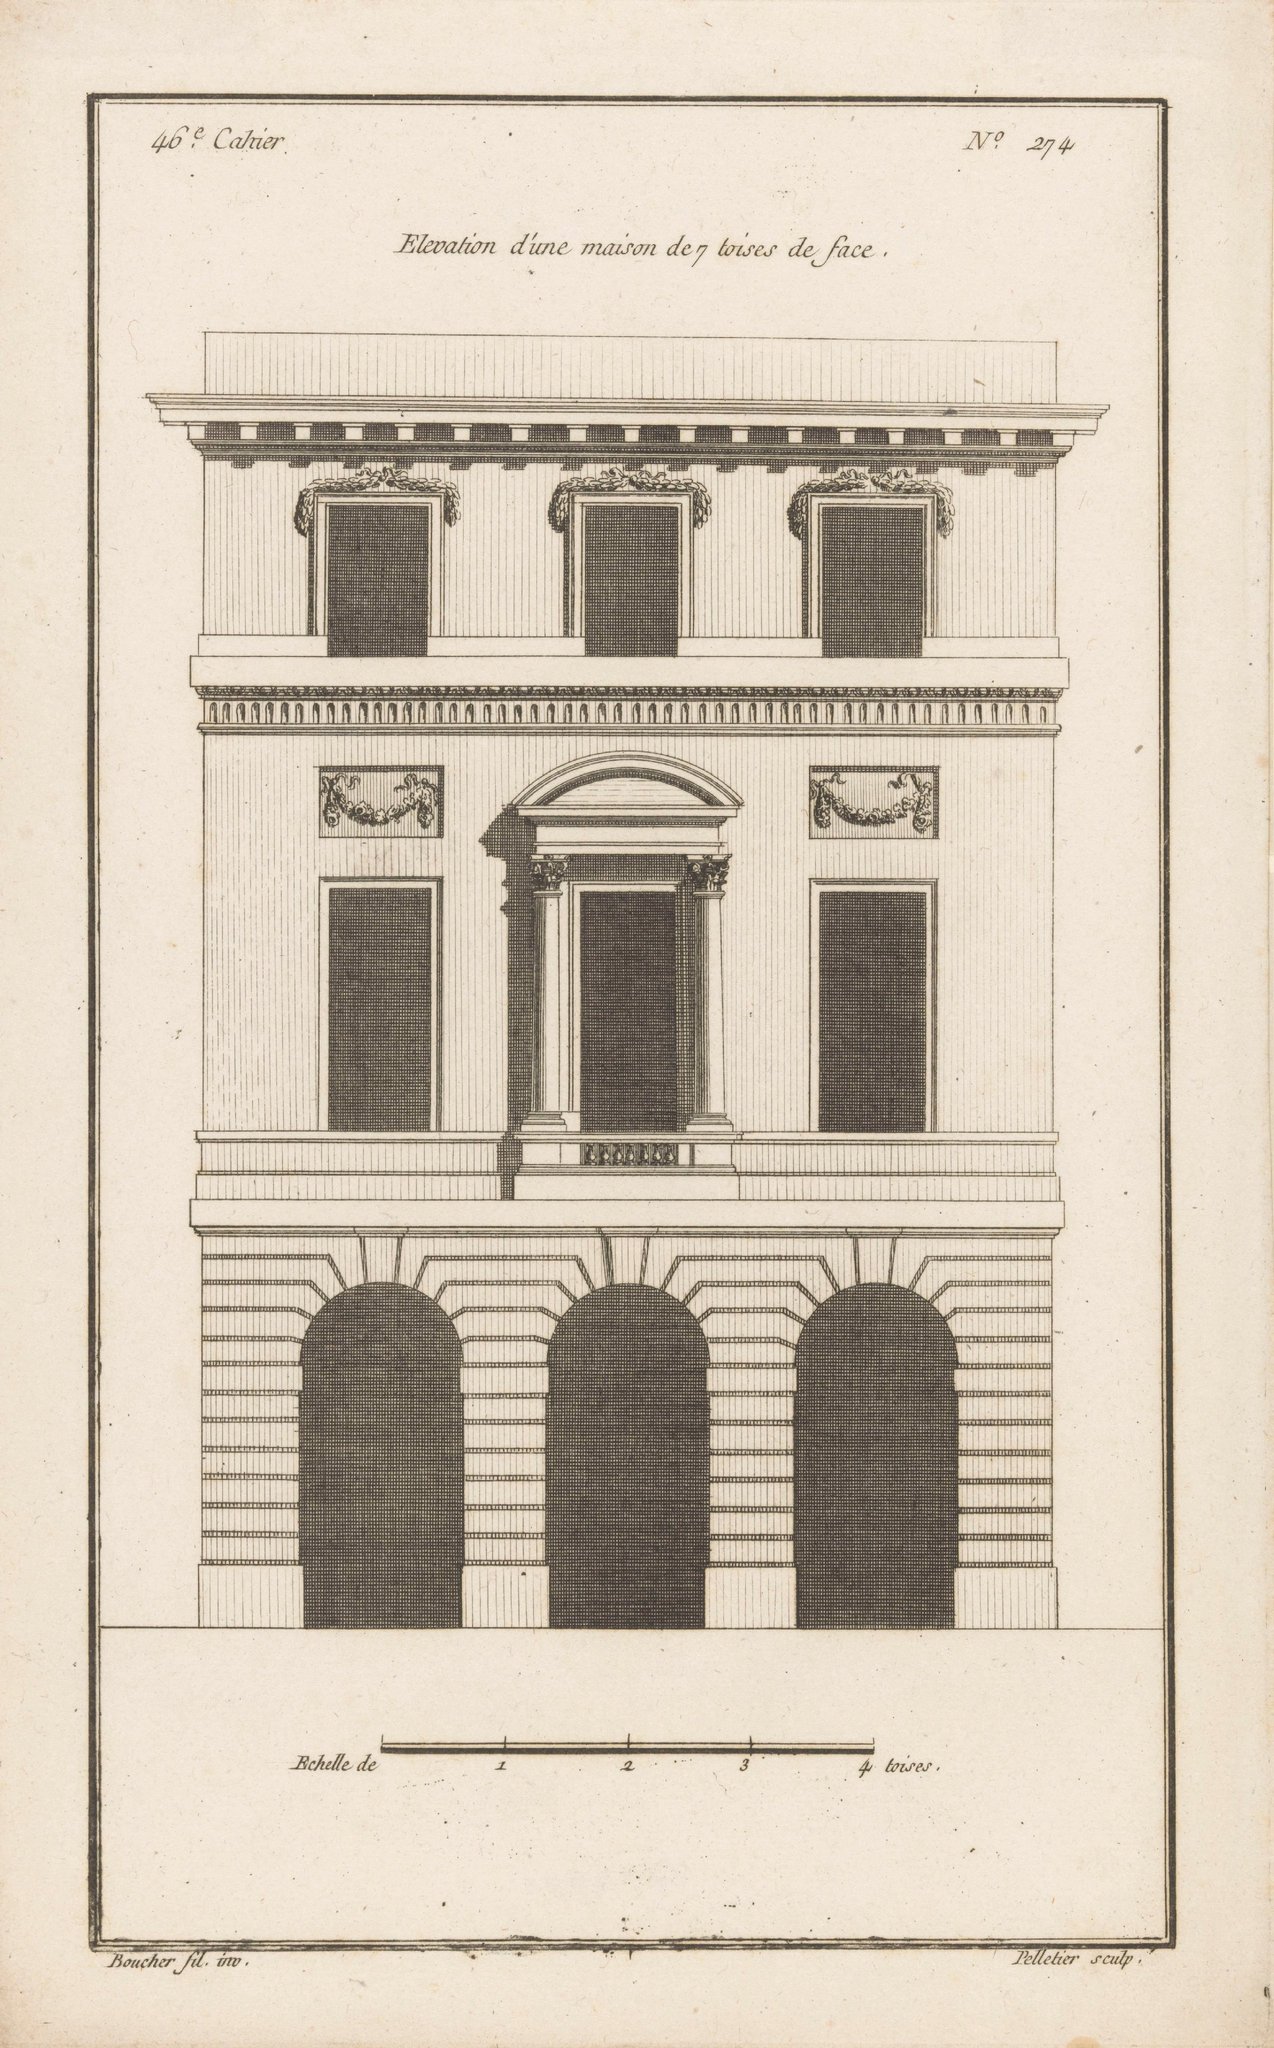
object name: ornament print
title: Façades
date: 1772-1779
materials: paper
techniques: engraving, etching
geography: paris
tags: column, pillar ~ architecture, other architectural details (with name), balcony, façade (of house or building), ornament ~ festoon, garland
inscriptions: collector's mark: Lugt 2228, collector's mark: Lugt 2760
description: Vooraanzicht en plattegrond van een façade van een huis met drie rondbogen en een balkon met zuilen en een halfrond fronton, gedecoreerd met guirlandes. Prentnummer 274.